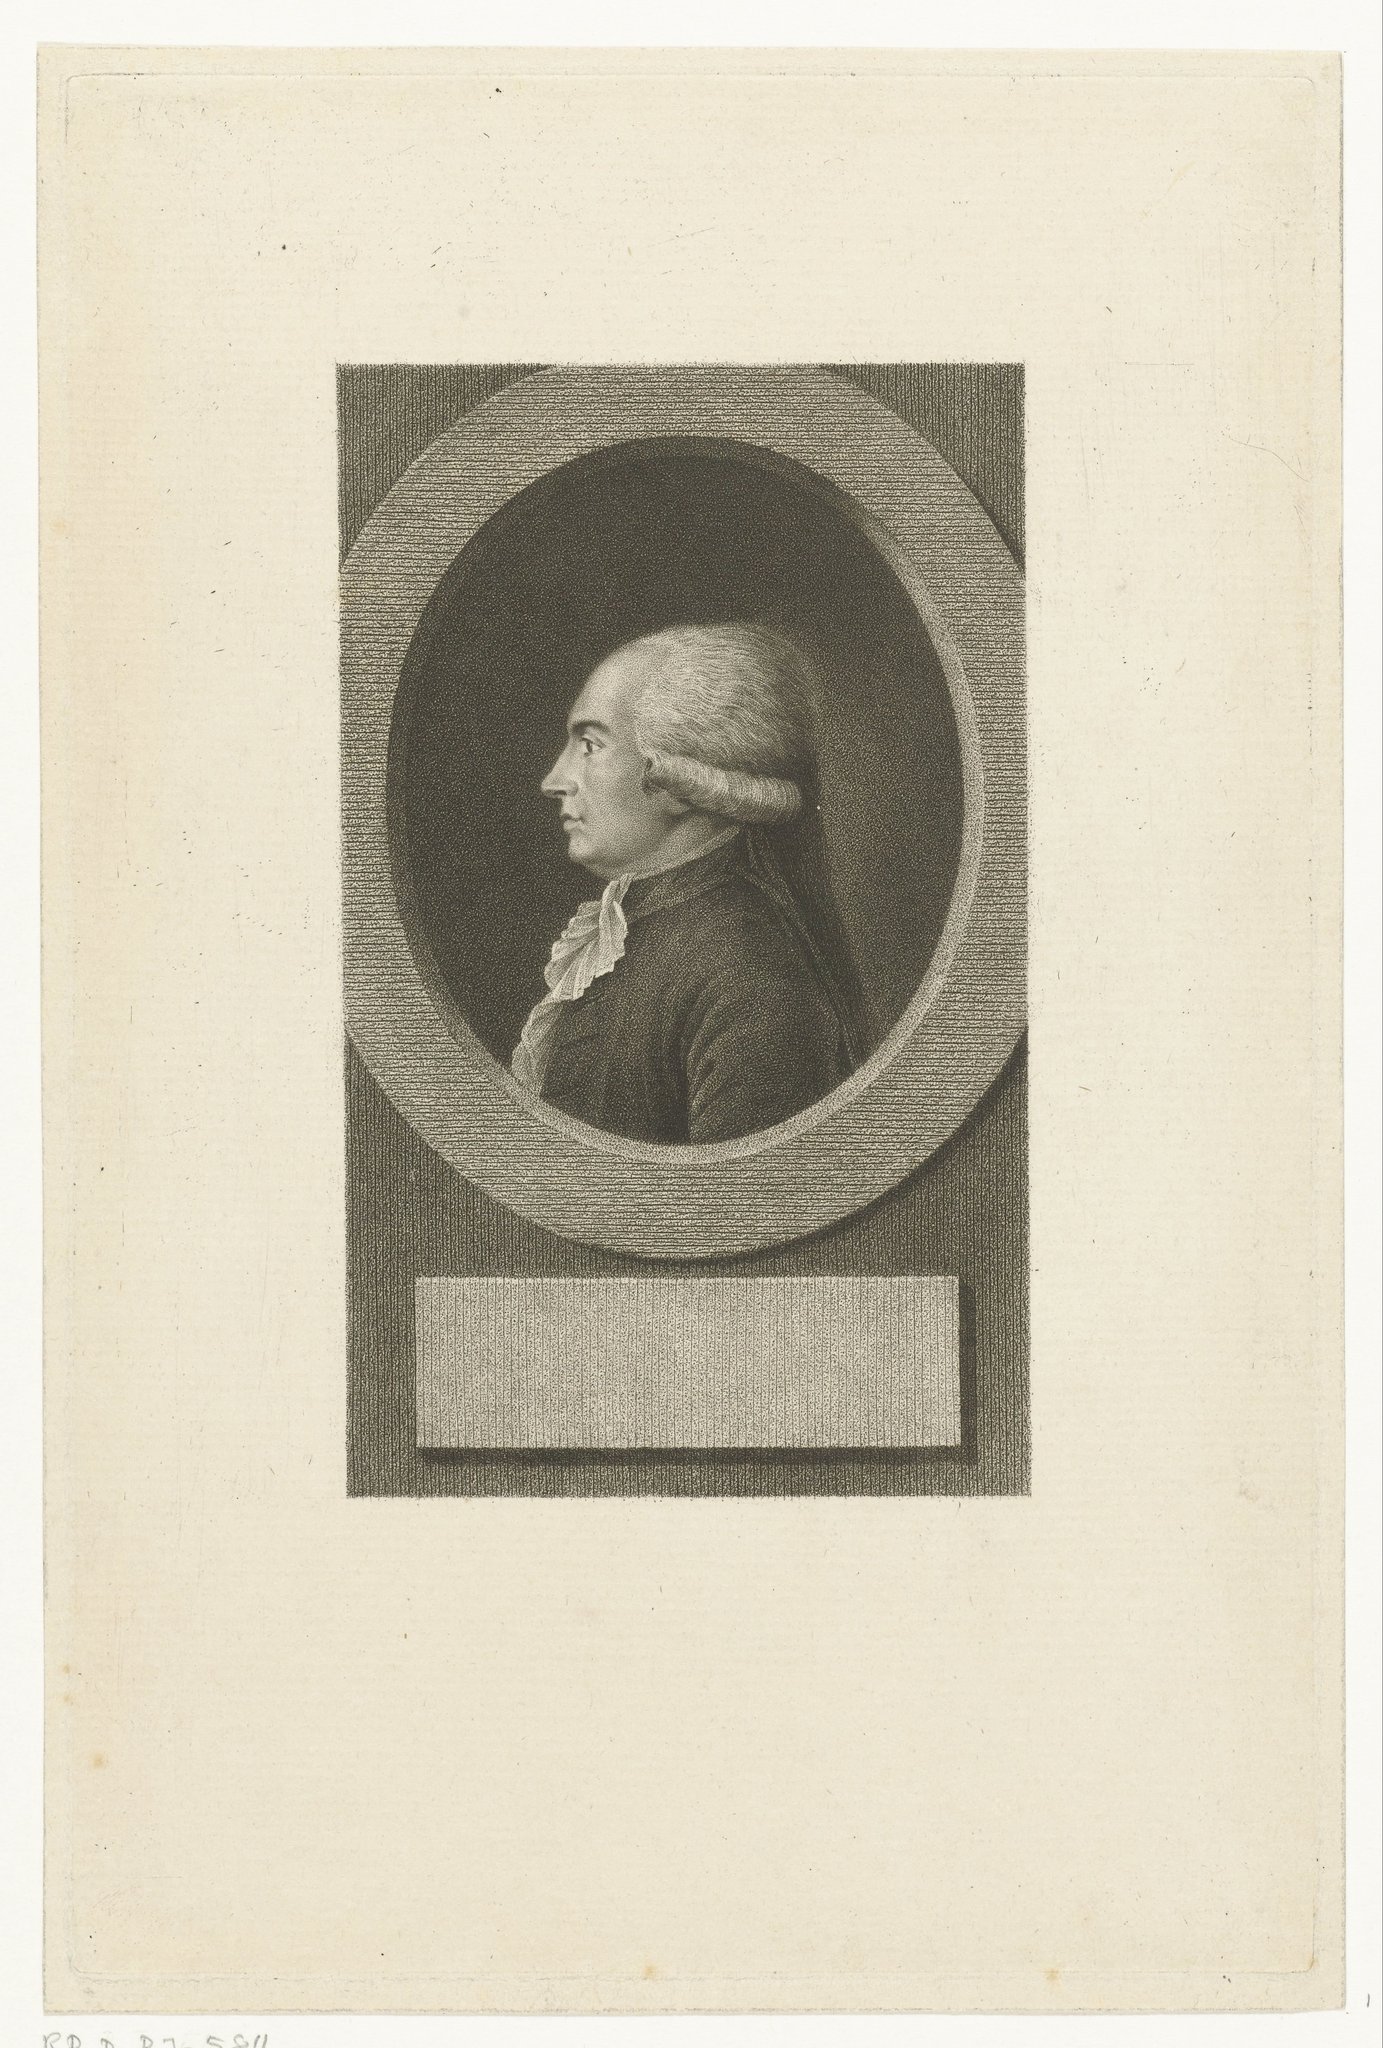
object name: print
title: Portret van Isaac René Guy le Chapelier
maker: lambertus antonius claessens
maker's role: draughtsman, print maker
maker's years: 1763-1834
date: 1792-1808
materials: paper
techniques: engraving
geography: amsterdam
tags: politician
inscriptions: collector's mark: Lugt 2228